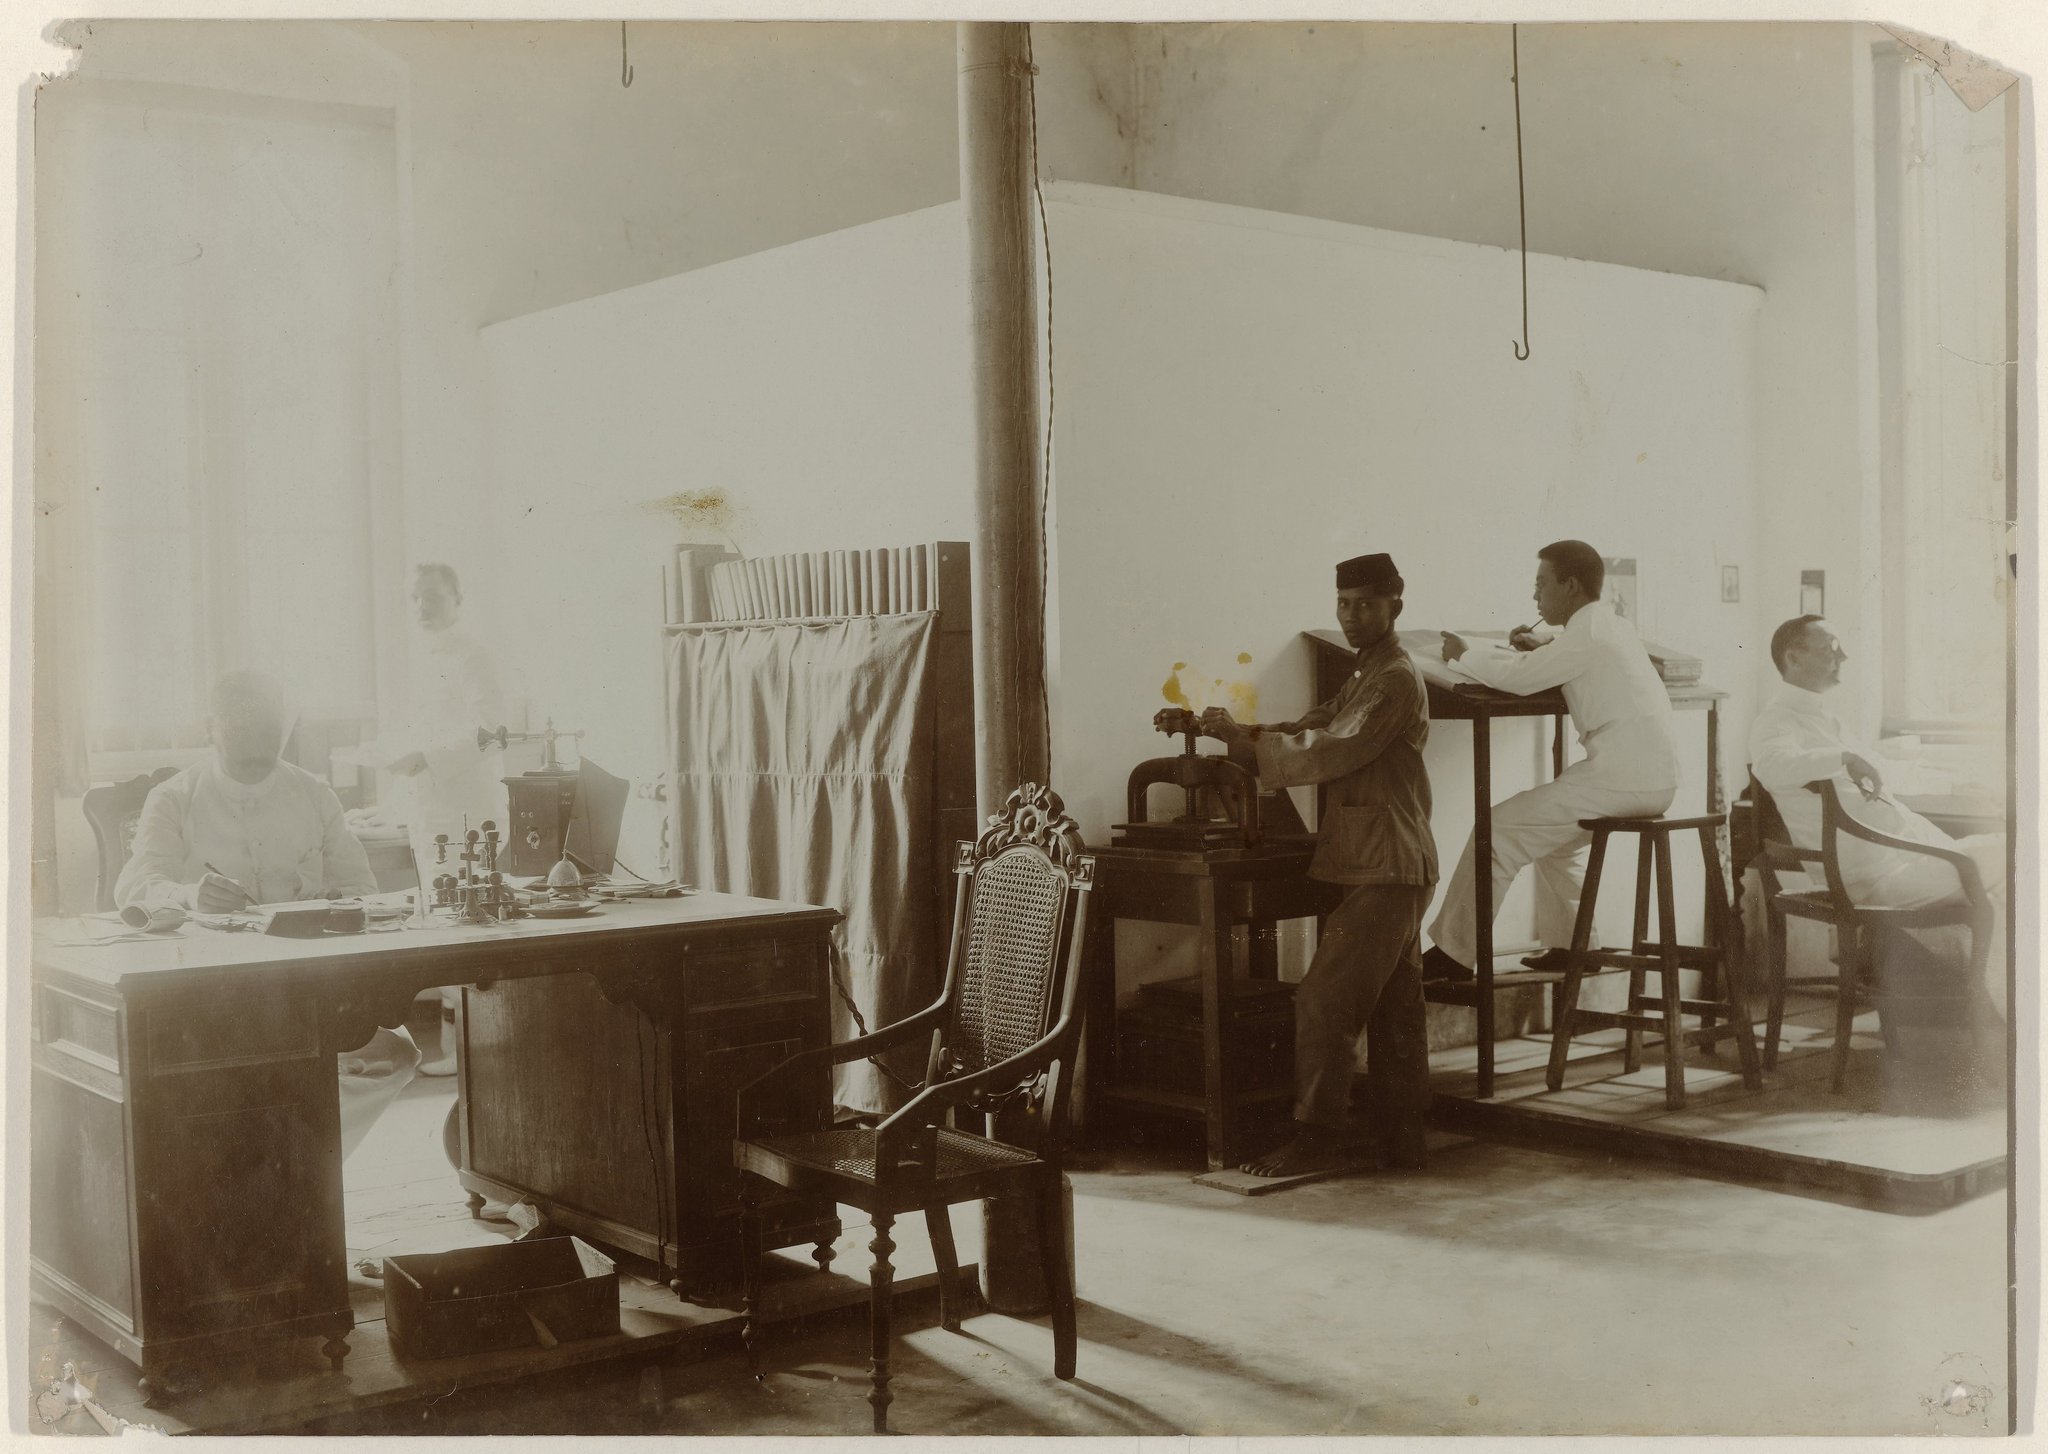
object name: photograph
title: Kantoor van de Deli Courant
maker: Anonymous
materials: photographic support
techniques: collodion silver print, gelatin silver print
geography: medan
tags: dutch east indies, the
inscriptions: inscription: ‘Kantoor’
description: Een kantoor van de Deli Courant te Medan, met verschillende zittende en staande werknemers. Onderdeel van een aparte groep van negen foto's uit 1908 binnen de gehele groep van 49 losse zwart-wit foto's van verschillend formaat over de uitgeverij en drukkerij van de krant Deli Courant in Medan in de periode 1885-1947.